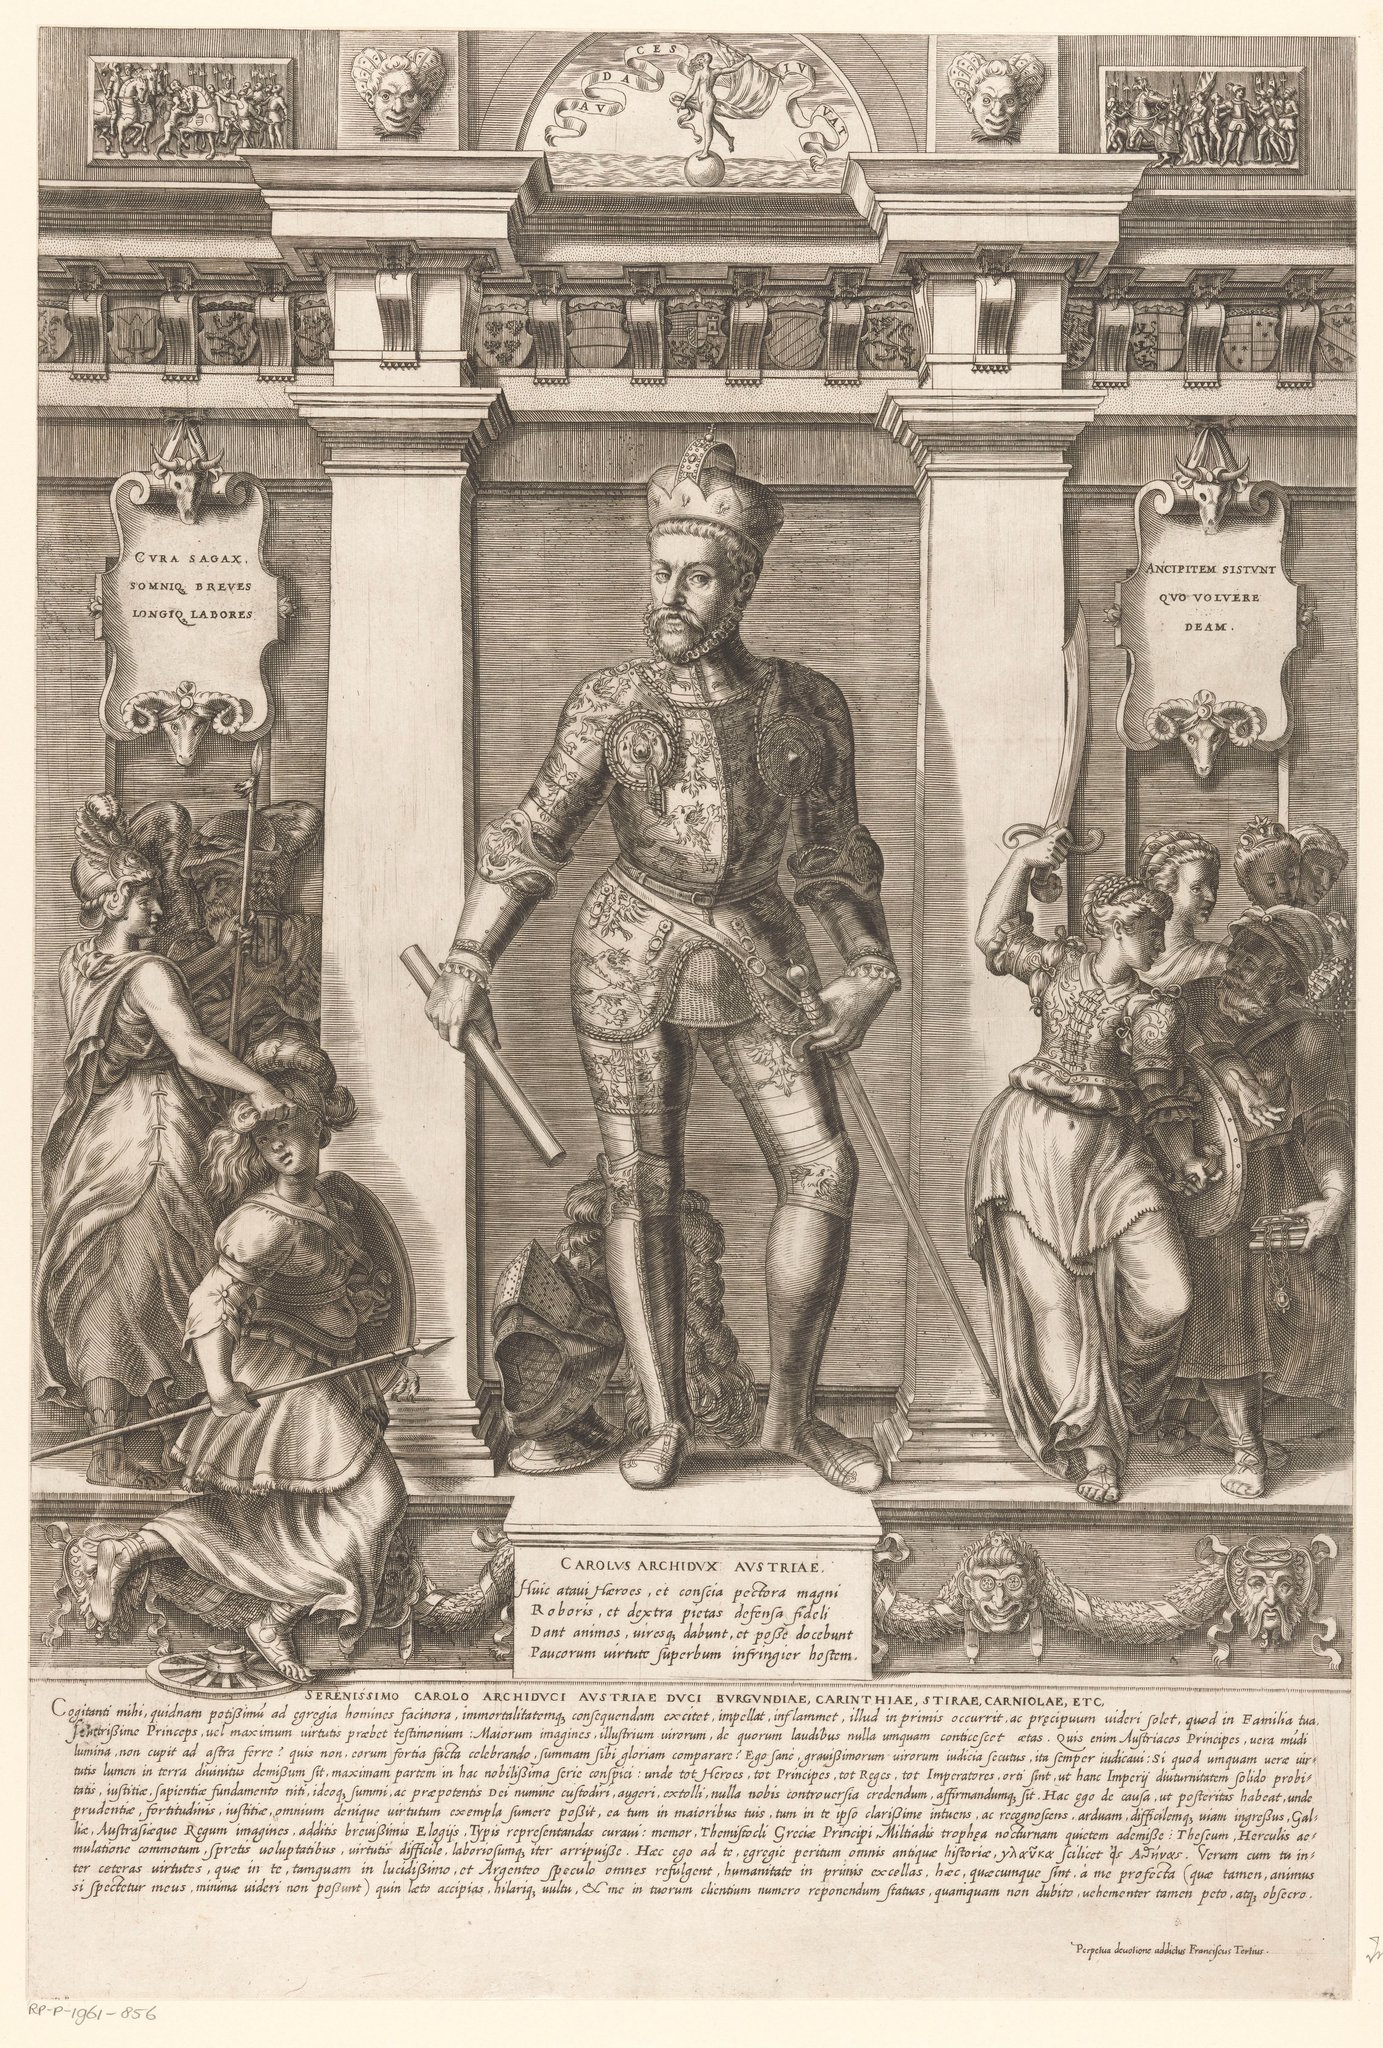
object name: print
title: Portretten van leden van het Oostenrijkse Huis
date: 1569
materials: paper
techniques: engraving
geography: italy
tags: vienna, karel ii (aartshertog van binnen-oostenrijk), historical persons, ruler, sovereign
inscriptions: collector's mark: Lugt 2228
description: Deze prent maakt deel uit van een reeks van 58 prenten. Het meerendeel van de prenten bevat portretten van 74 leden van het Oostenrijkse Huis, naar tekeningen door Francesco Terzio, die deels getekend zijn naar de 28 levensgrote bronzen beelden die rond de cenotaaf van Maximiliaan I in de Hofkirche te Innsbruck staan.